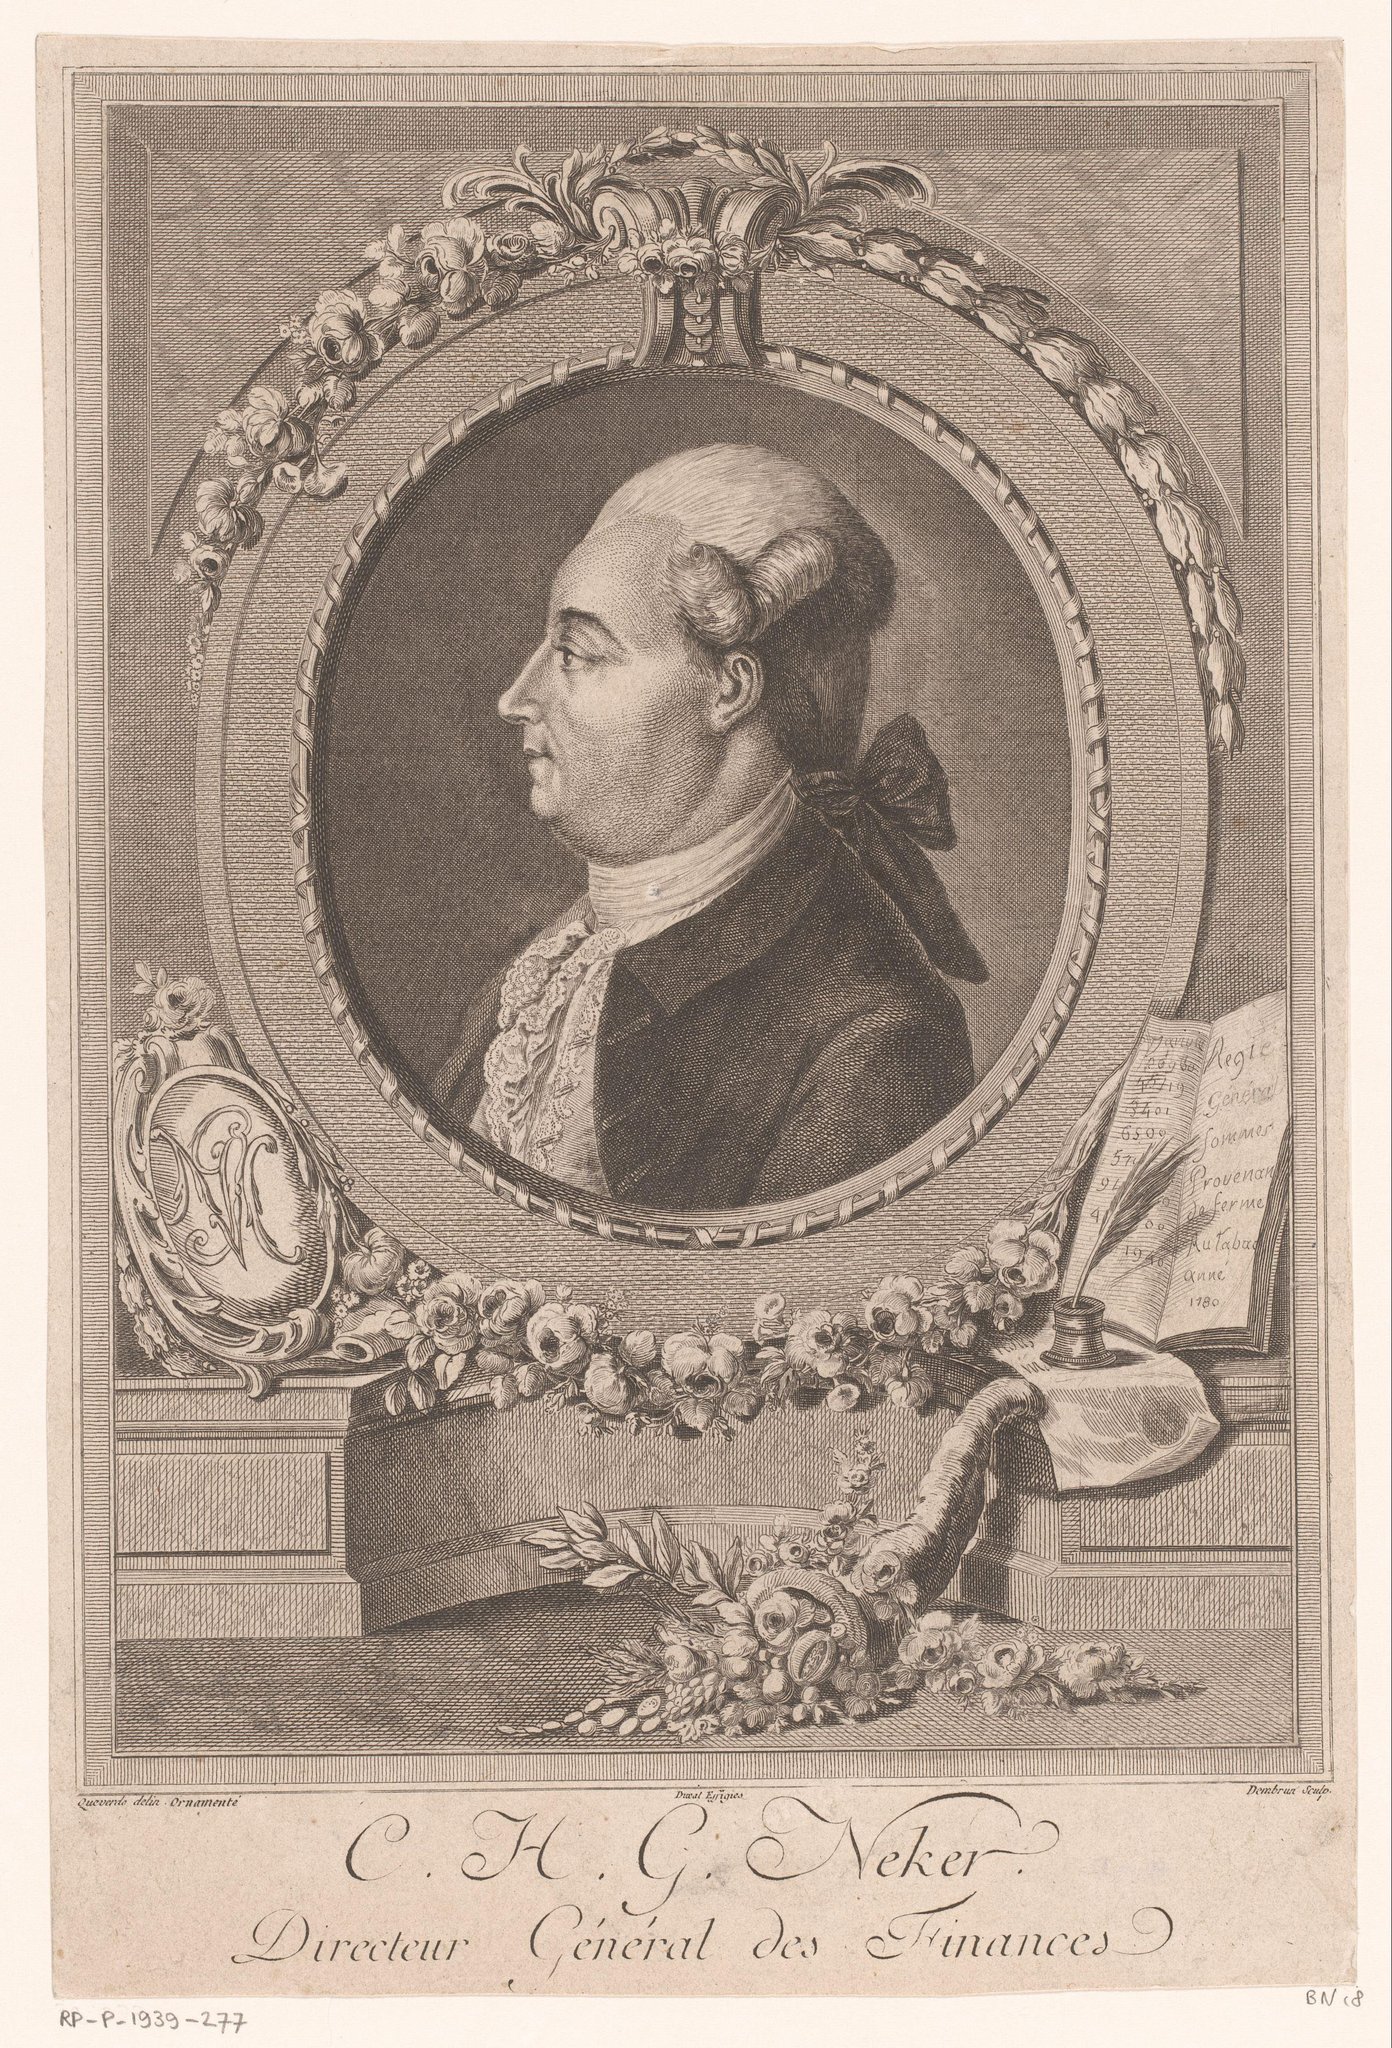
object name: print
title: Portret van Jacques Necker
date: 1751-1808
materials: paper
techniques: etching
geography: france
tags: historical persons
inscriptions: collector's mark: Lugt 2228, collector's mark: Lugt 2760, collector's mark: Lugt 2656